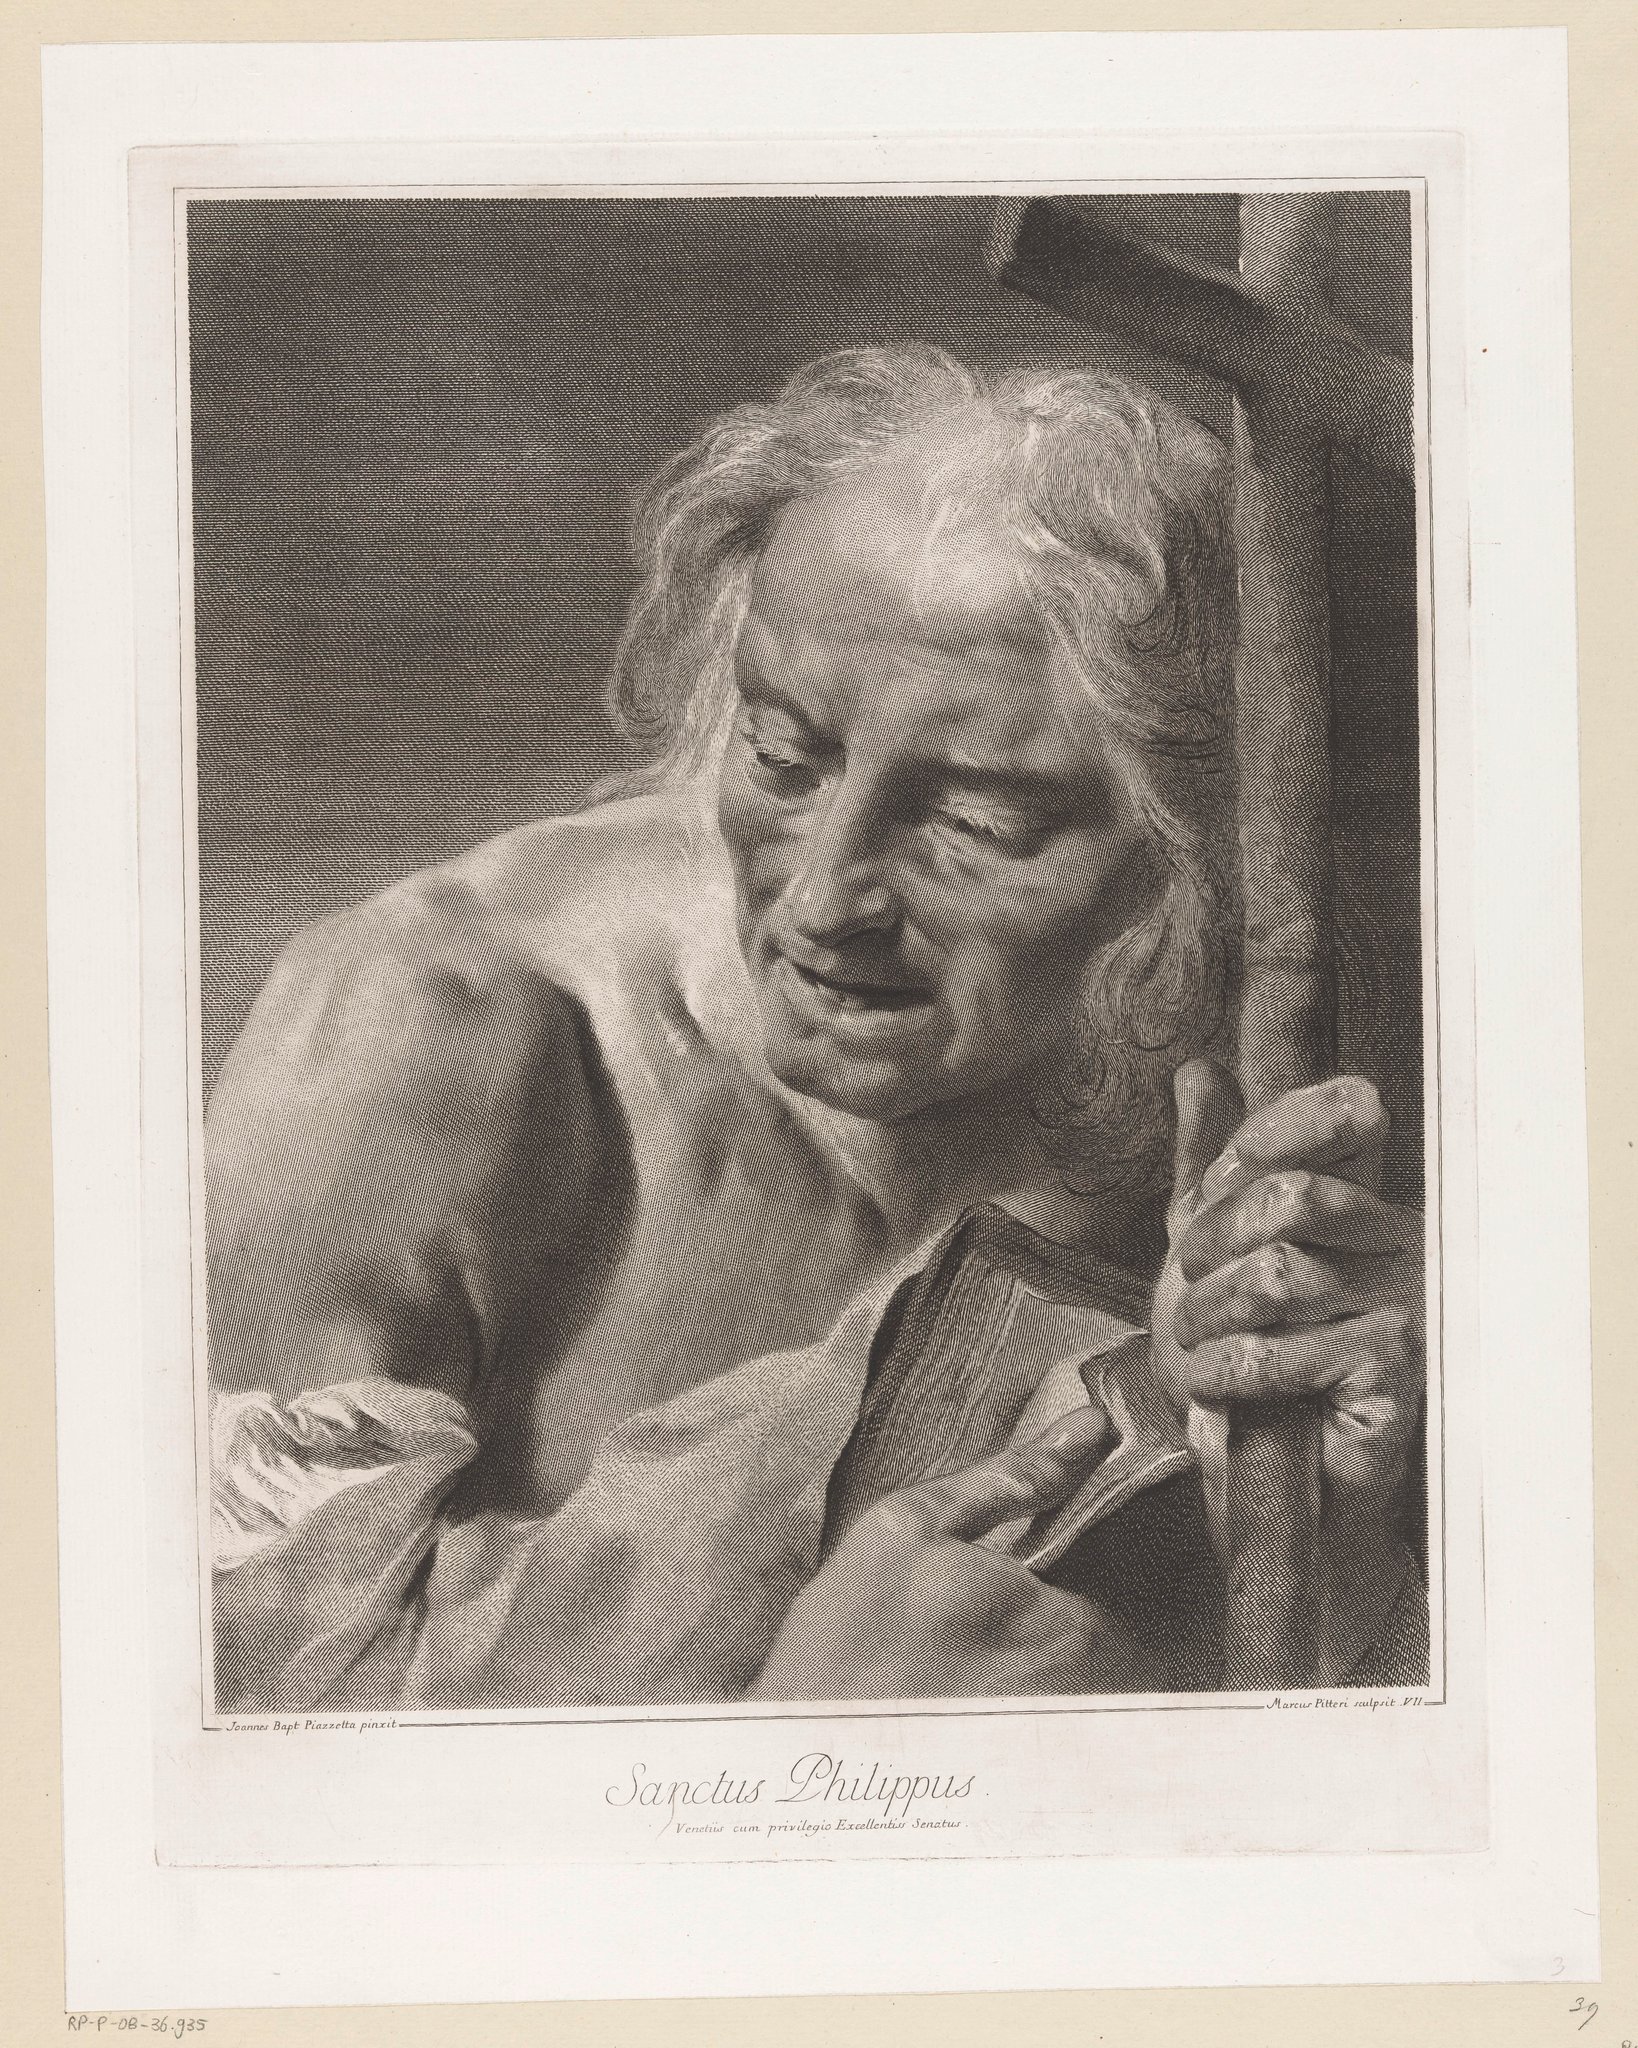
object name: print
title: Sanctus Philippus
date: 1712-1786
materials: paper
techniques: engraving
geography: venice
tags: the apostle philip; possible attributes: book, cross, dish with snake, lance, scroll, stone, sword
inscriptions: collector's mark: Lugt 240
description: Deze prent maakt deel uit van een reeks van 12 prenten.